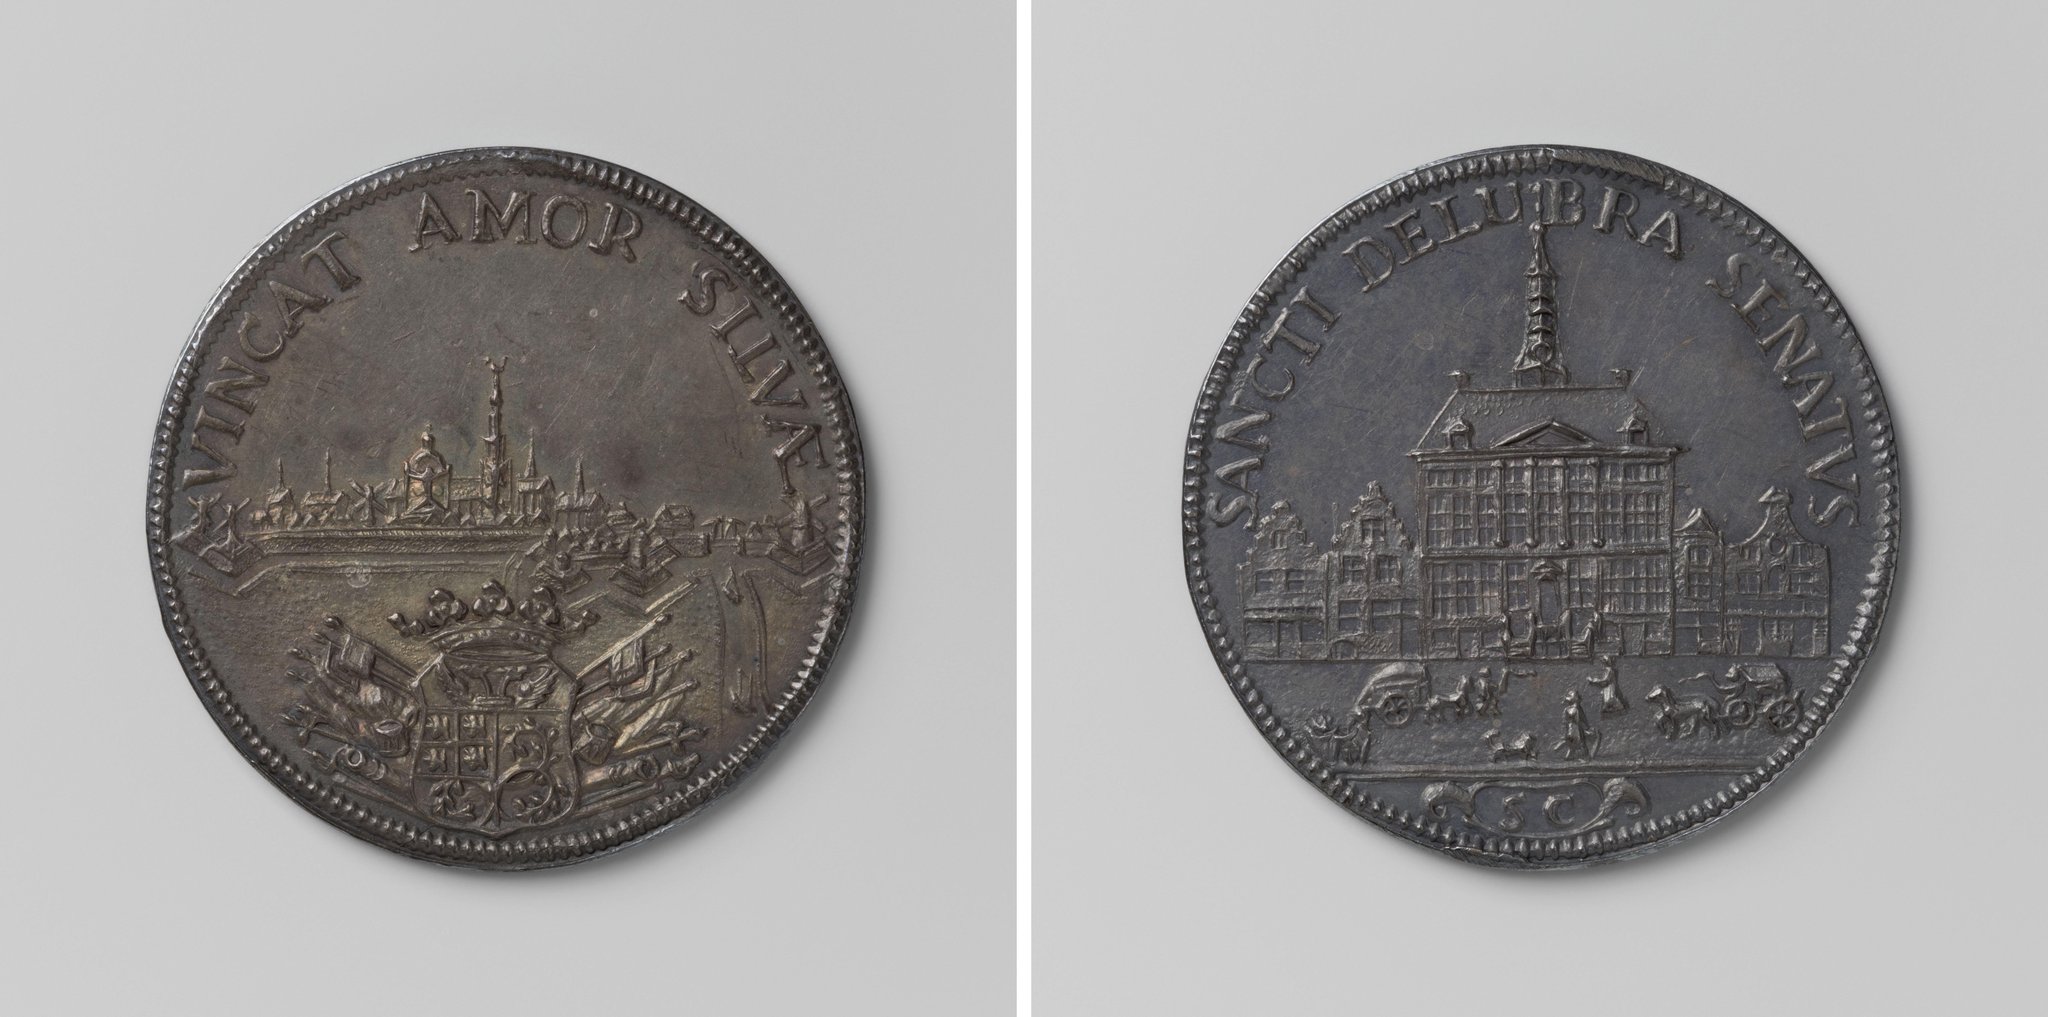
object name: council medal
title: Vroedschapspenning van de stad 's-Hertogenbosch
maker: theodorus casparus van berckel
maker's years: 1680-1734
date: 1714-1720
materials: silver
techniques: striking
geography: den bosch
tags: den bosch